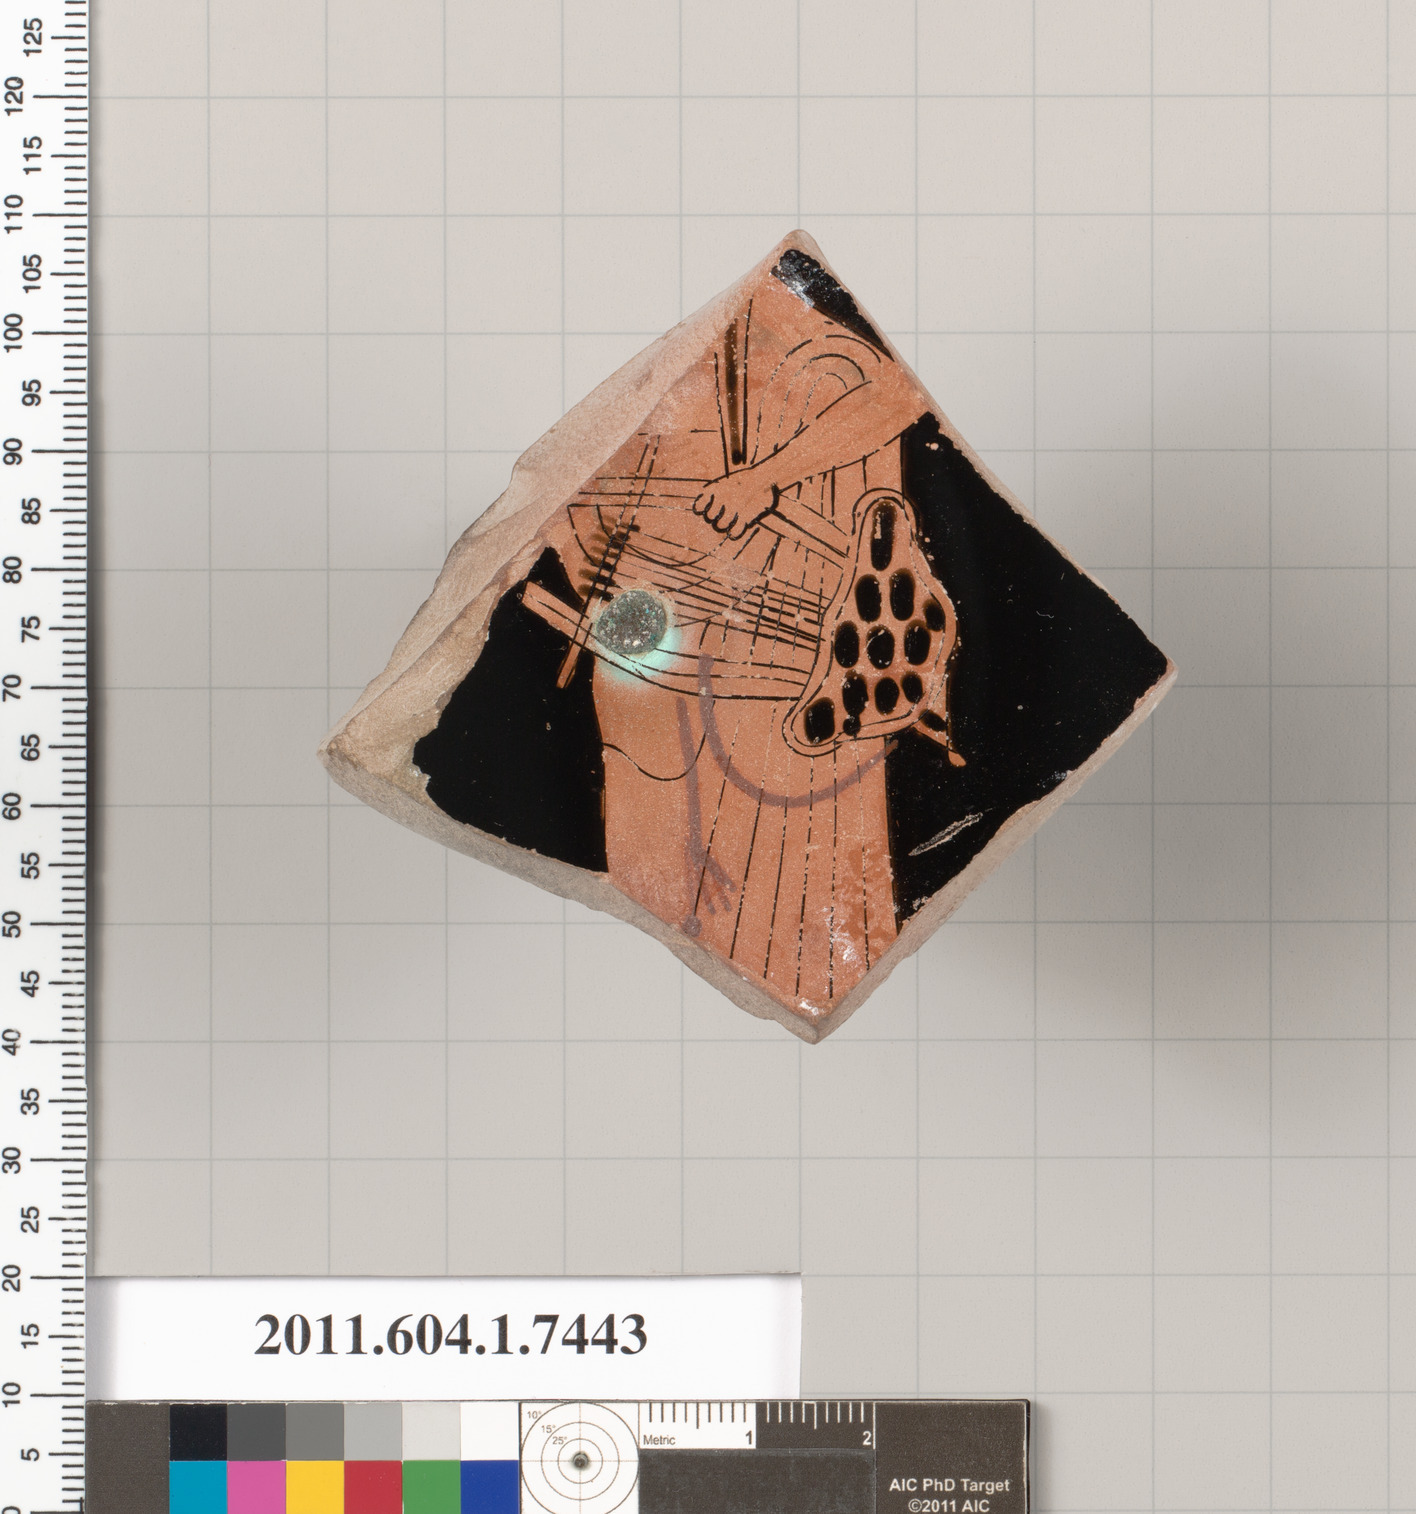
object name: kylix fragment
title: Terracotta fragment of a kylix (drinking cup)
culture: greek, attic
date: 490-470 BCE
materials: terracotta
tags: lyres